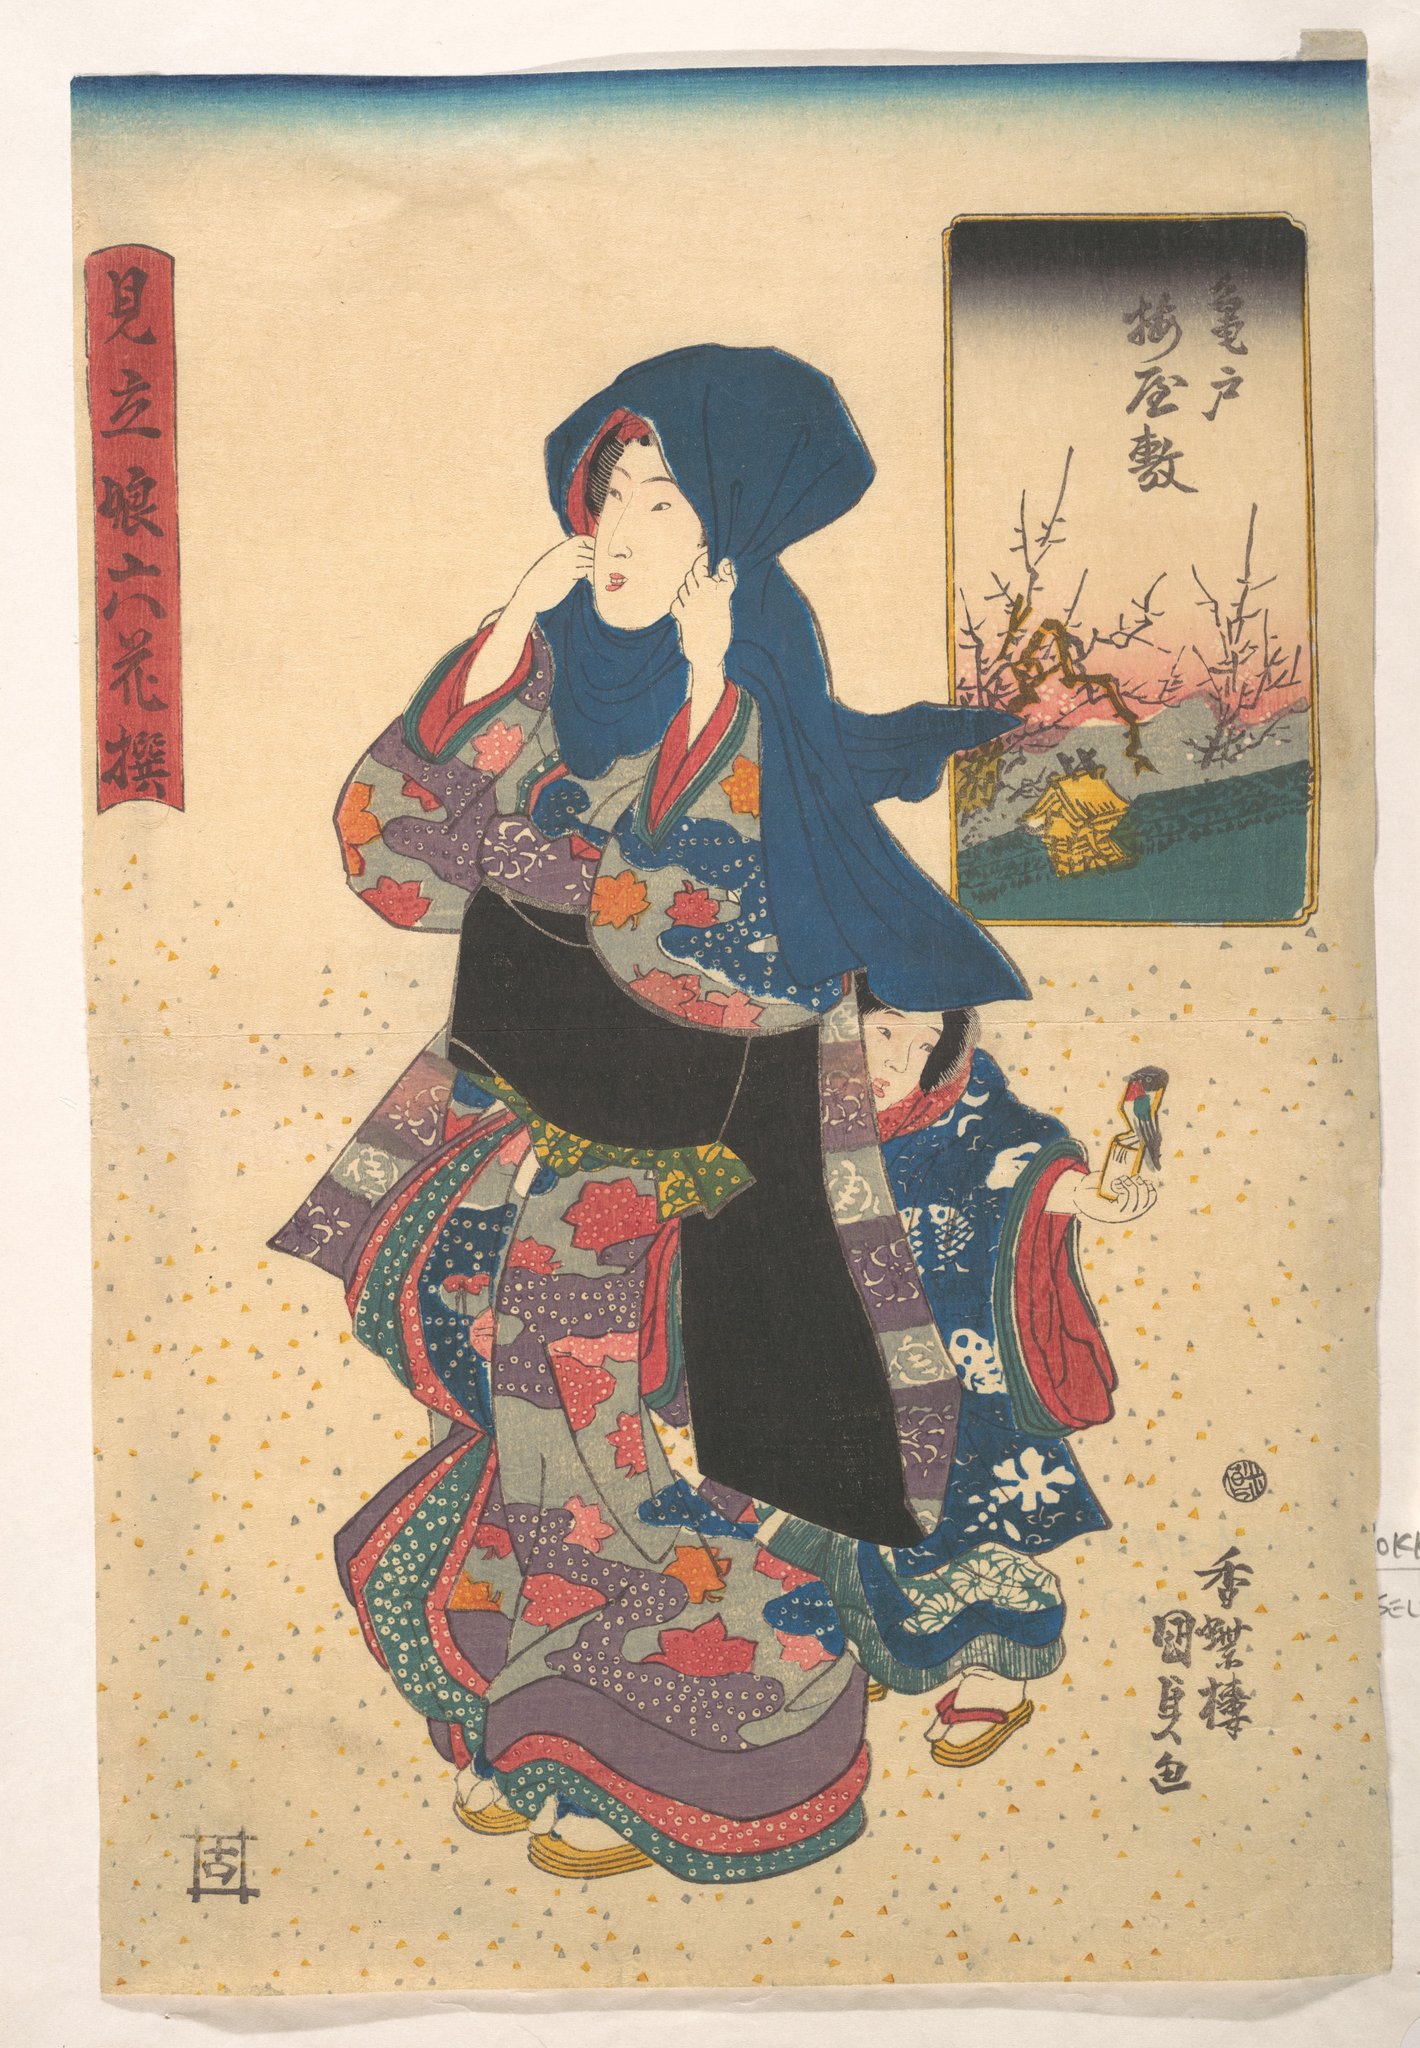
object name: print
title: Six Poetic Sages as Young Women at the Plum Garden at Kameido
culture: japanese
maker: utagawa kunisada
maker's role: artist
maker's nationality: japanese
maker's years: 1786-1864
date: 1801-1900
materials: ink, paper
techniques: woodblock print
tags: girls,women